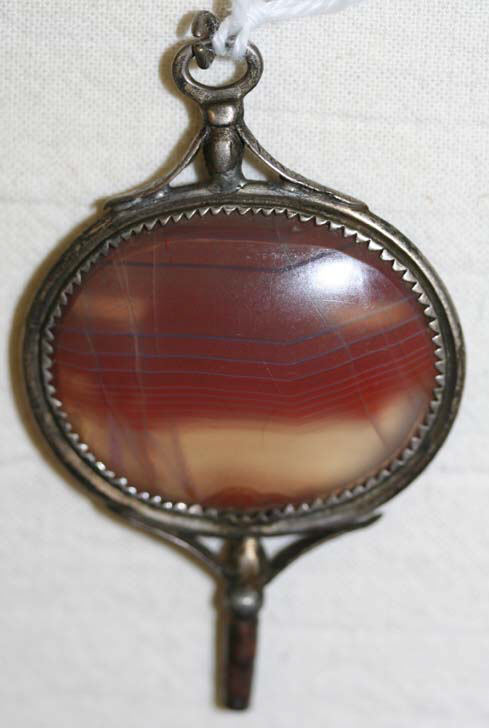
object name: fob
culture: european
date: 1801-1833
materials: silver